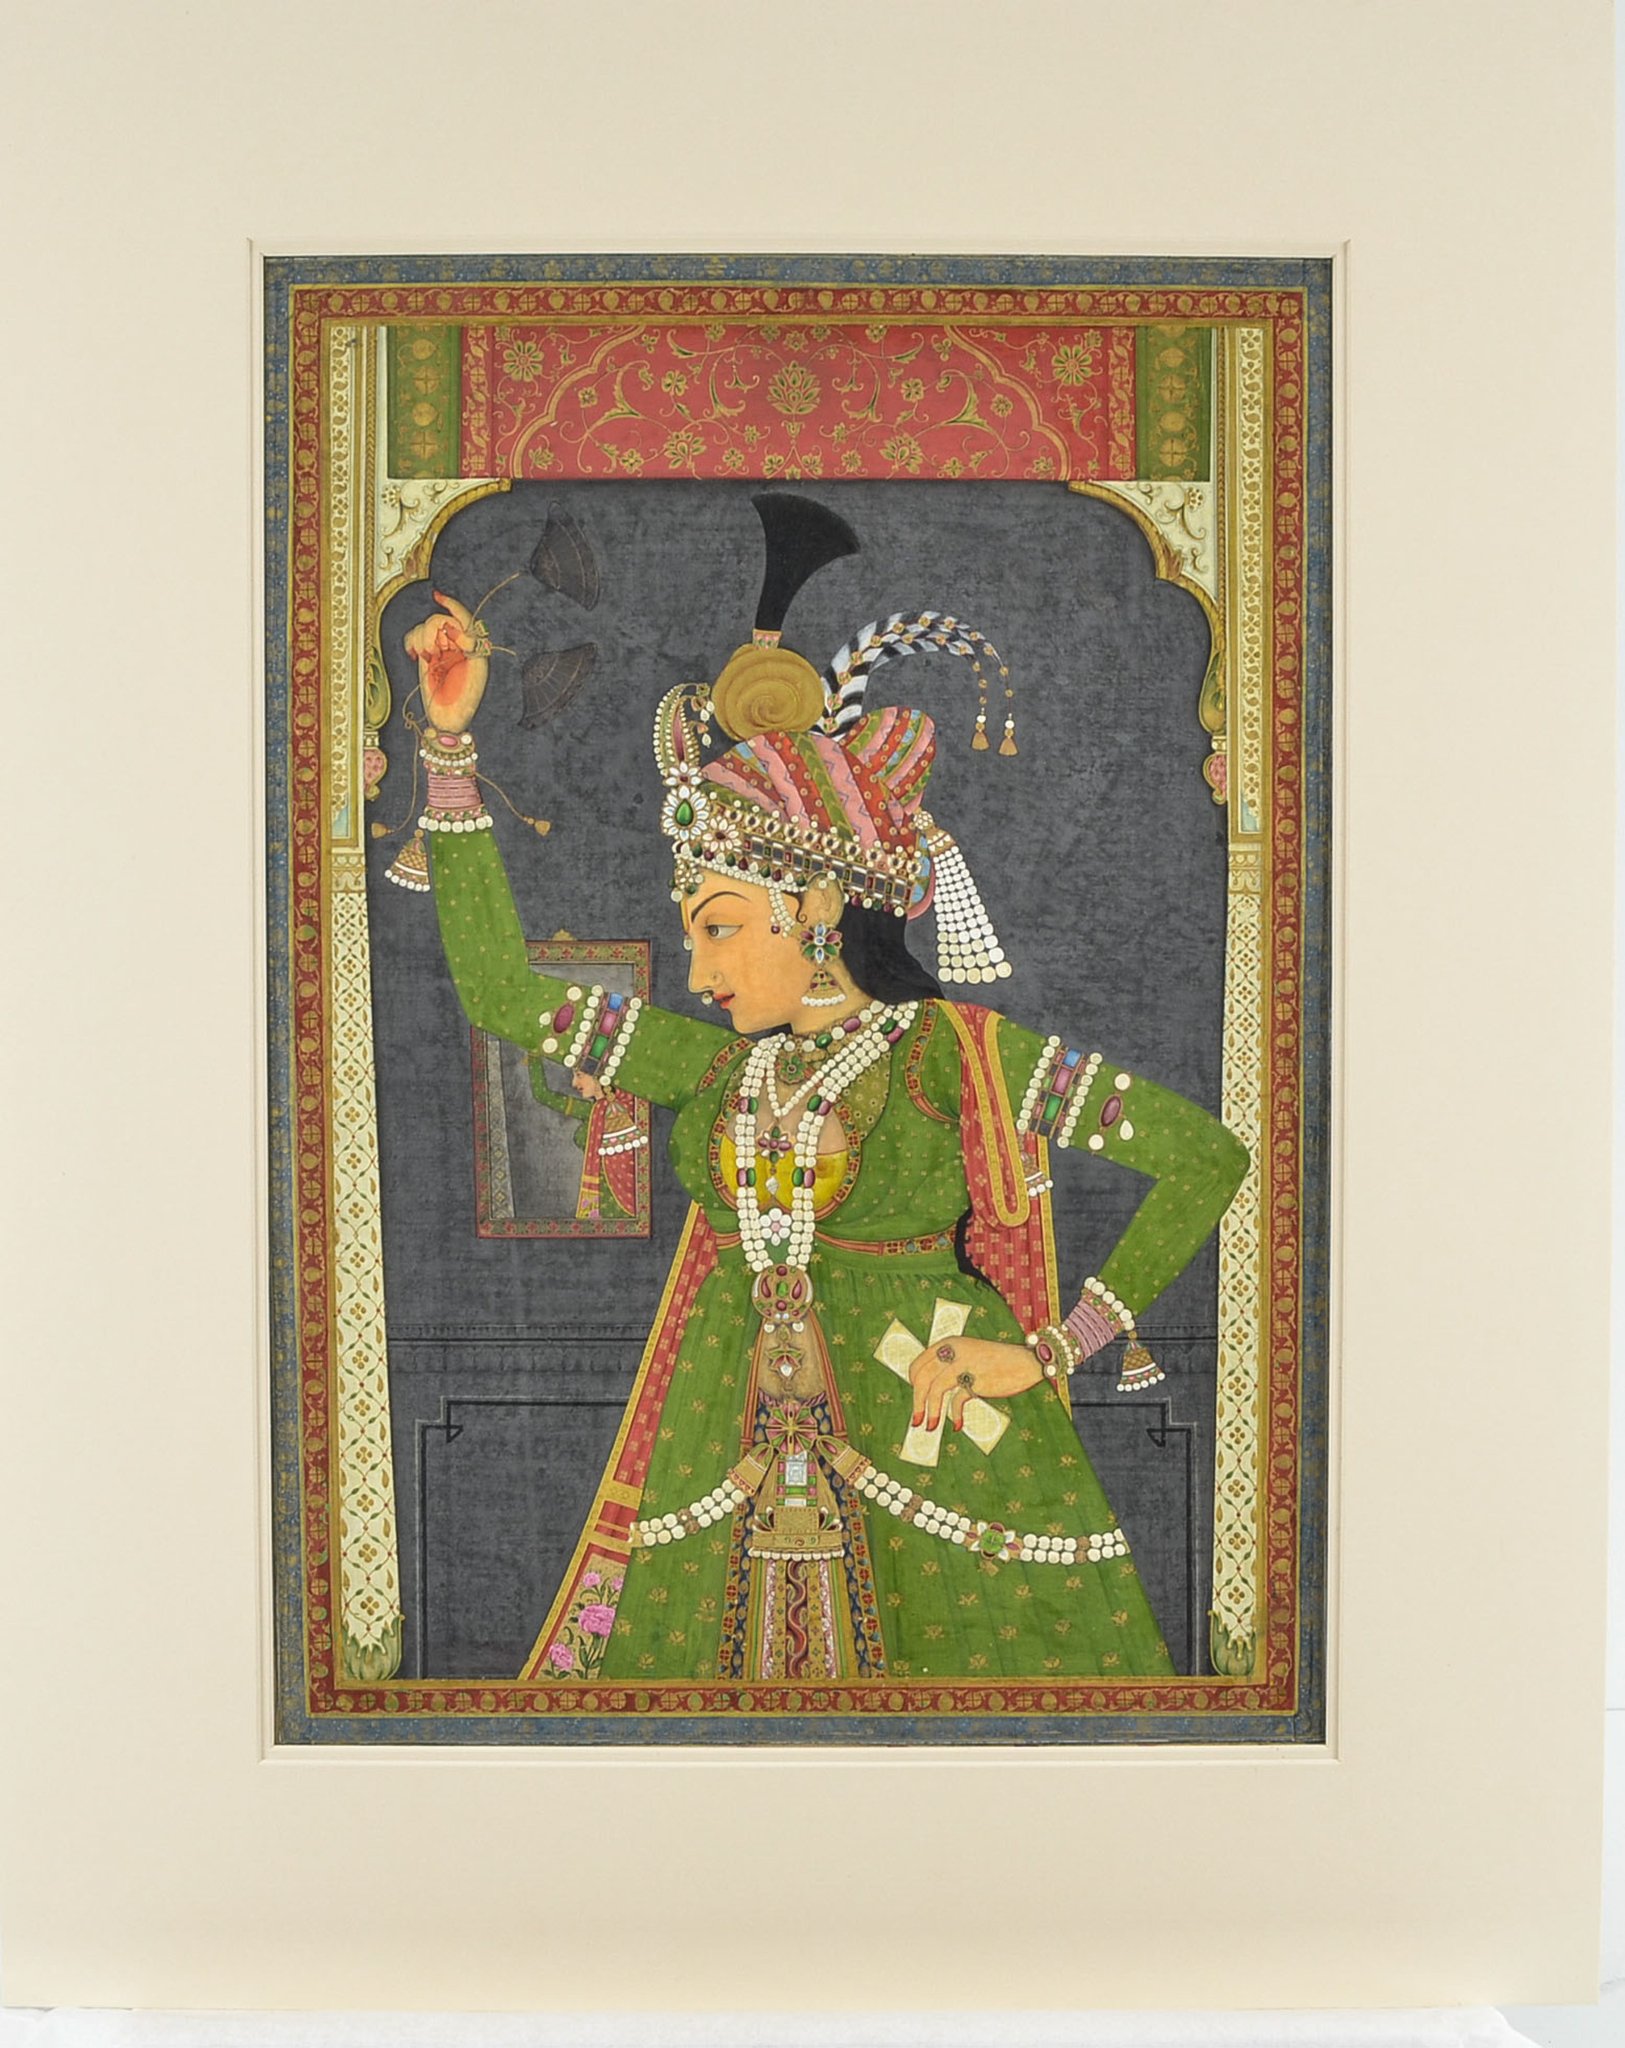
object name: painting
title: A Woman of the Court Dressed as Radha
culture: indian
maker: ramji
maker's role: artist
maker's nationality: indian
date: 1767-1800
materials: gold, paper, silver, watercolor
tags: dresses,profiles,women